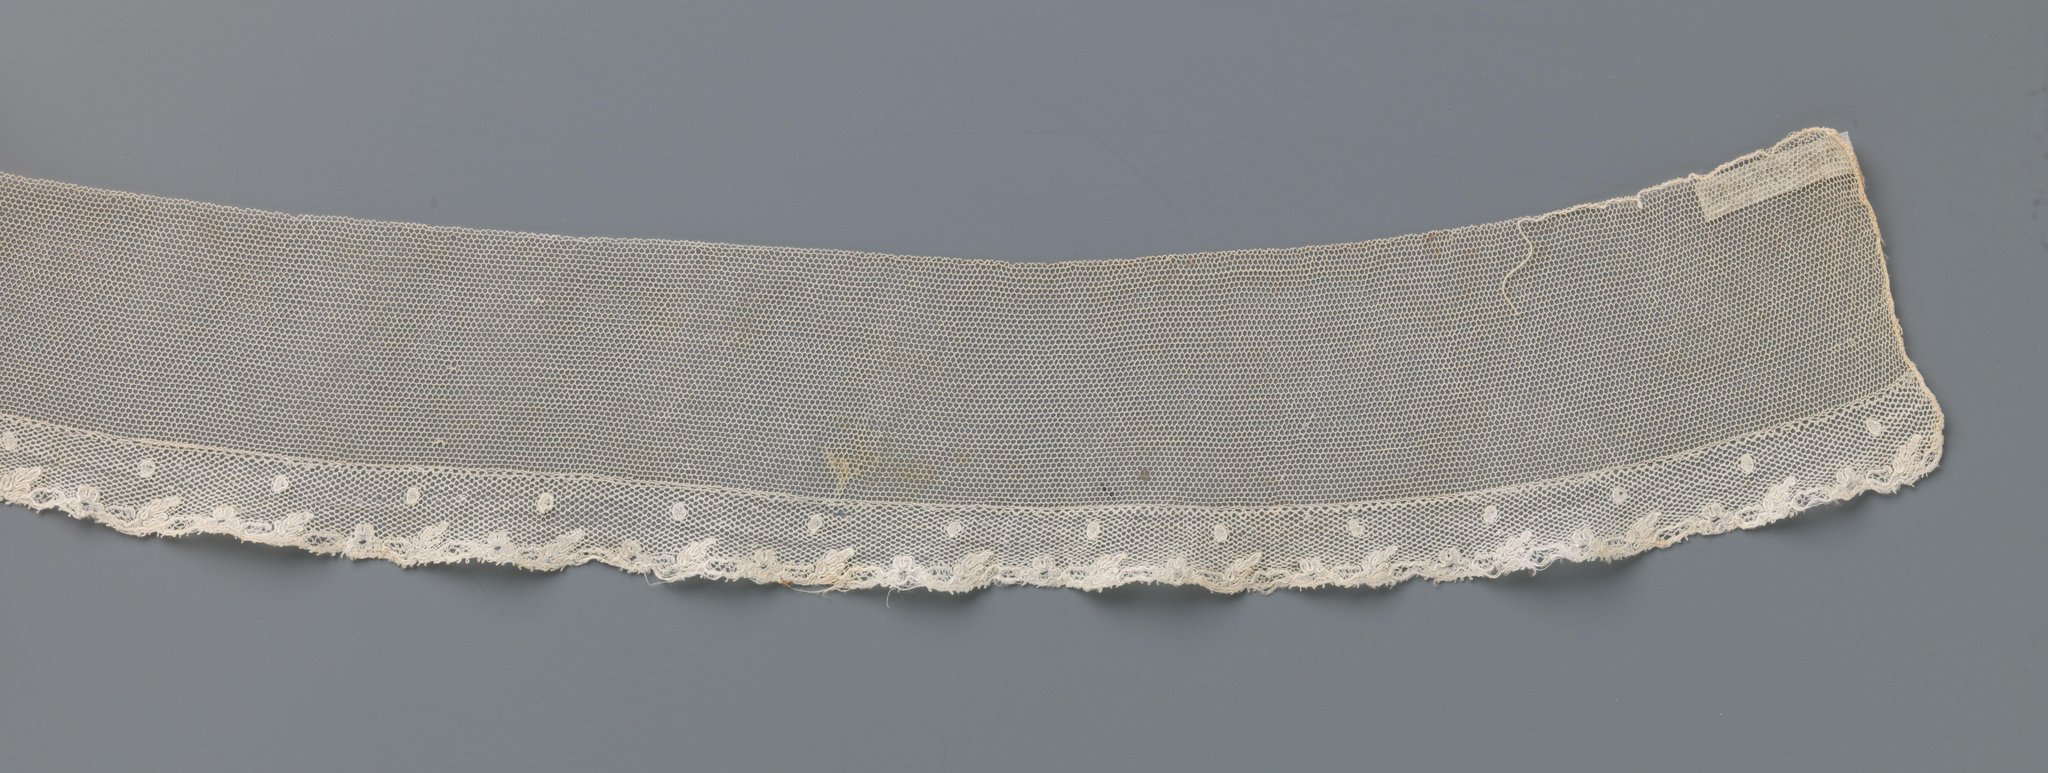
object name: strip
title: Strook machinale tule met smalle strook kloskant met moesjes en een rand van ovaaltjes en rozetbloempjes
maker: Anonymous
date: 1775-1795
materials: linen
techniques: lace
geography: southern netherlands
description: Strook naturelkleurige kant, bestaande uit een brede strook machinale tule, met daaronder een smalle strook kloskant: Mechelse kant. Het patroon van de gekloste strook bestaat uit een rij moesjes met langs de rechte onderzijde een aaneengeschakeling van zeer kleine ovaaltjes afgewisseld door een rozetbloempje en een schuin omhoog stekend blaadje. De spaarzame motieven zijn gemaakt in linnenlag en zijn voorzien van dikkere en glimmende contourdraden. De motieven zijn met elkaar verbonden door een fijne traliegrond, de Mechelse grond. De lange zijden zijn recht afgewerkt, met langs de onderzijde van de gekloste strook picots. Eén korte zijde is afgewerkt met een zoompje.